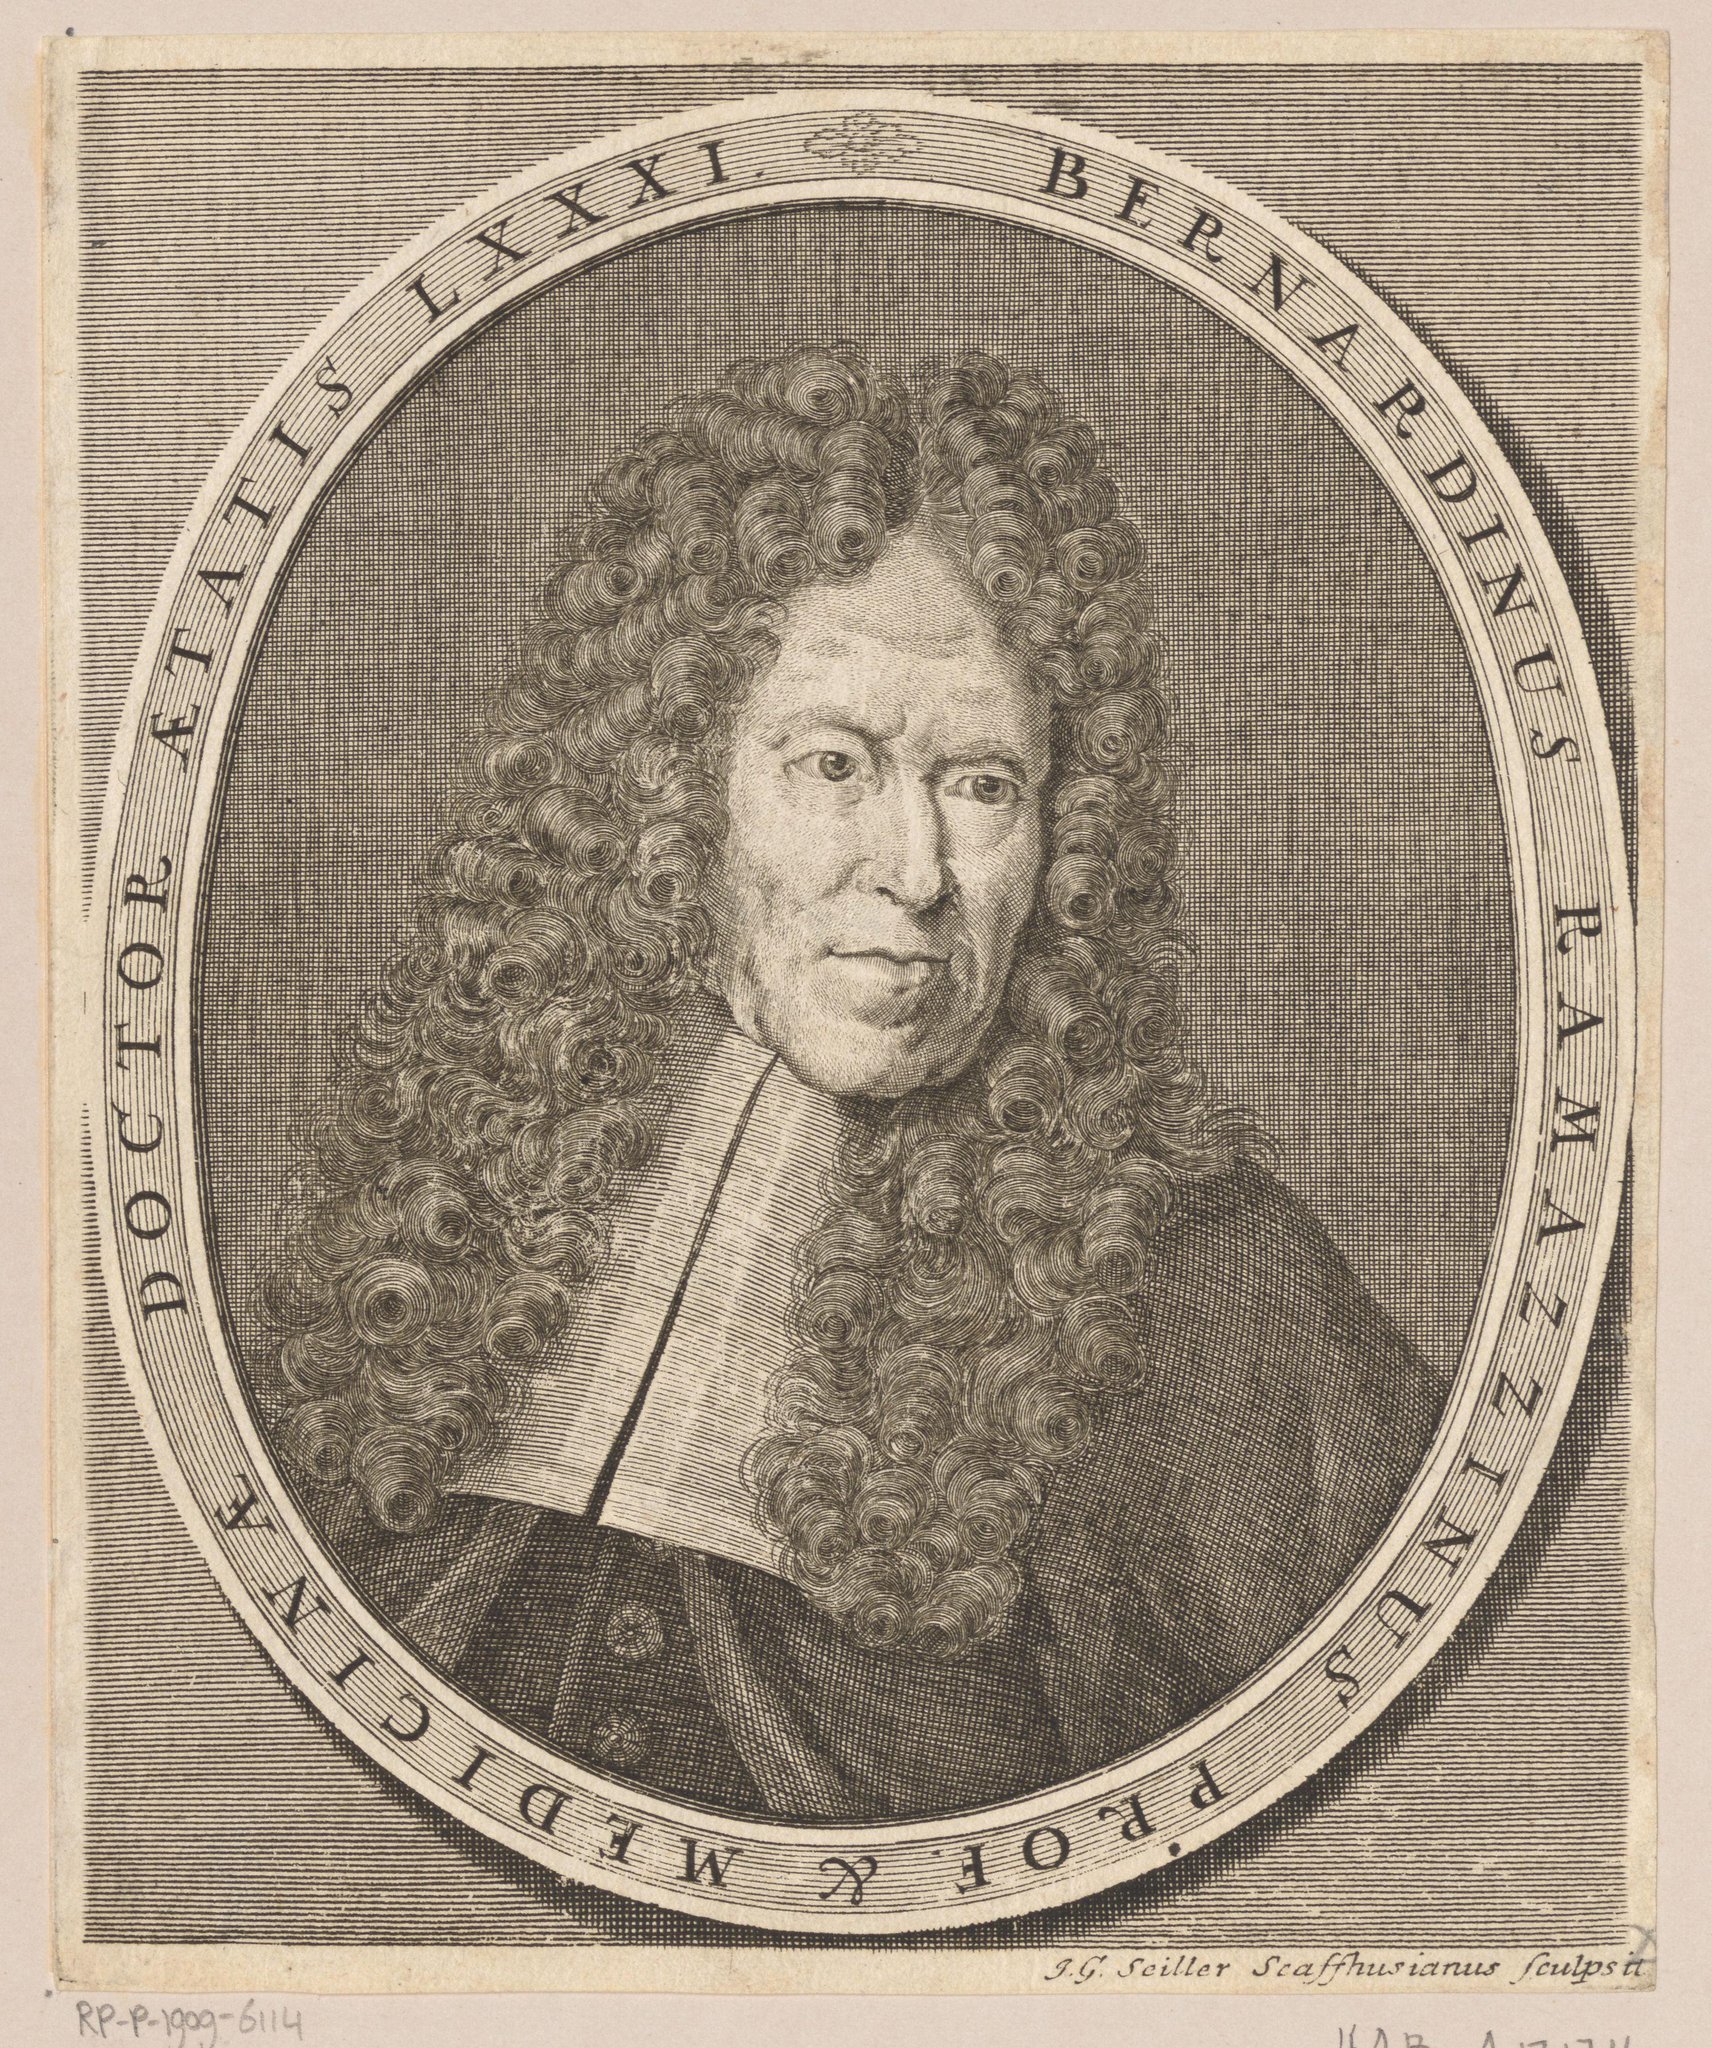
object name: print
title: Portret van Bernardino Ramazzini op 81-jarige leeftijd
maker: johann georg seiller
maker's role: print maker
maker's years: 1663-1740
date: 1716-1717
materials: paper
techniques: engraving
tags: historical persons, physician, doctor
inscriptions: collector's mark: Lugt 2228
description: Prent mogelijk uit: Ramazzini, Bernardino. Opera omnia medica & physiologica (...). Genève: Cramer & Perichon, 1716. Of uit een latere editie (1717).